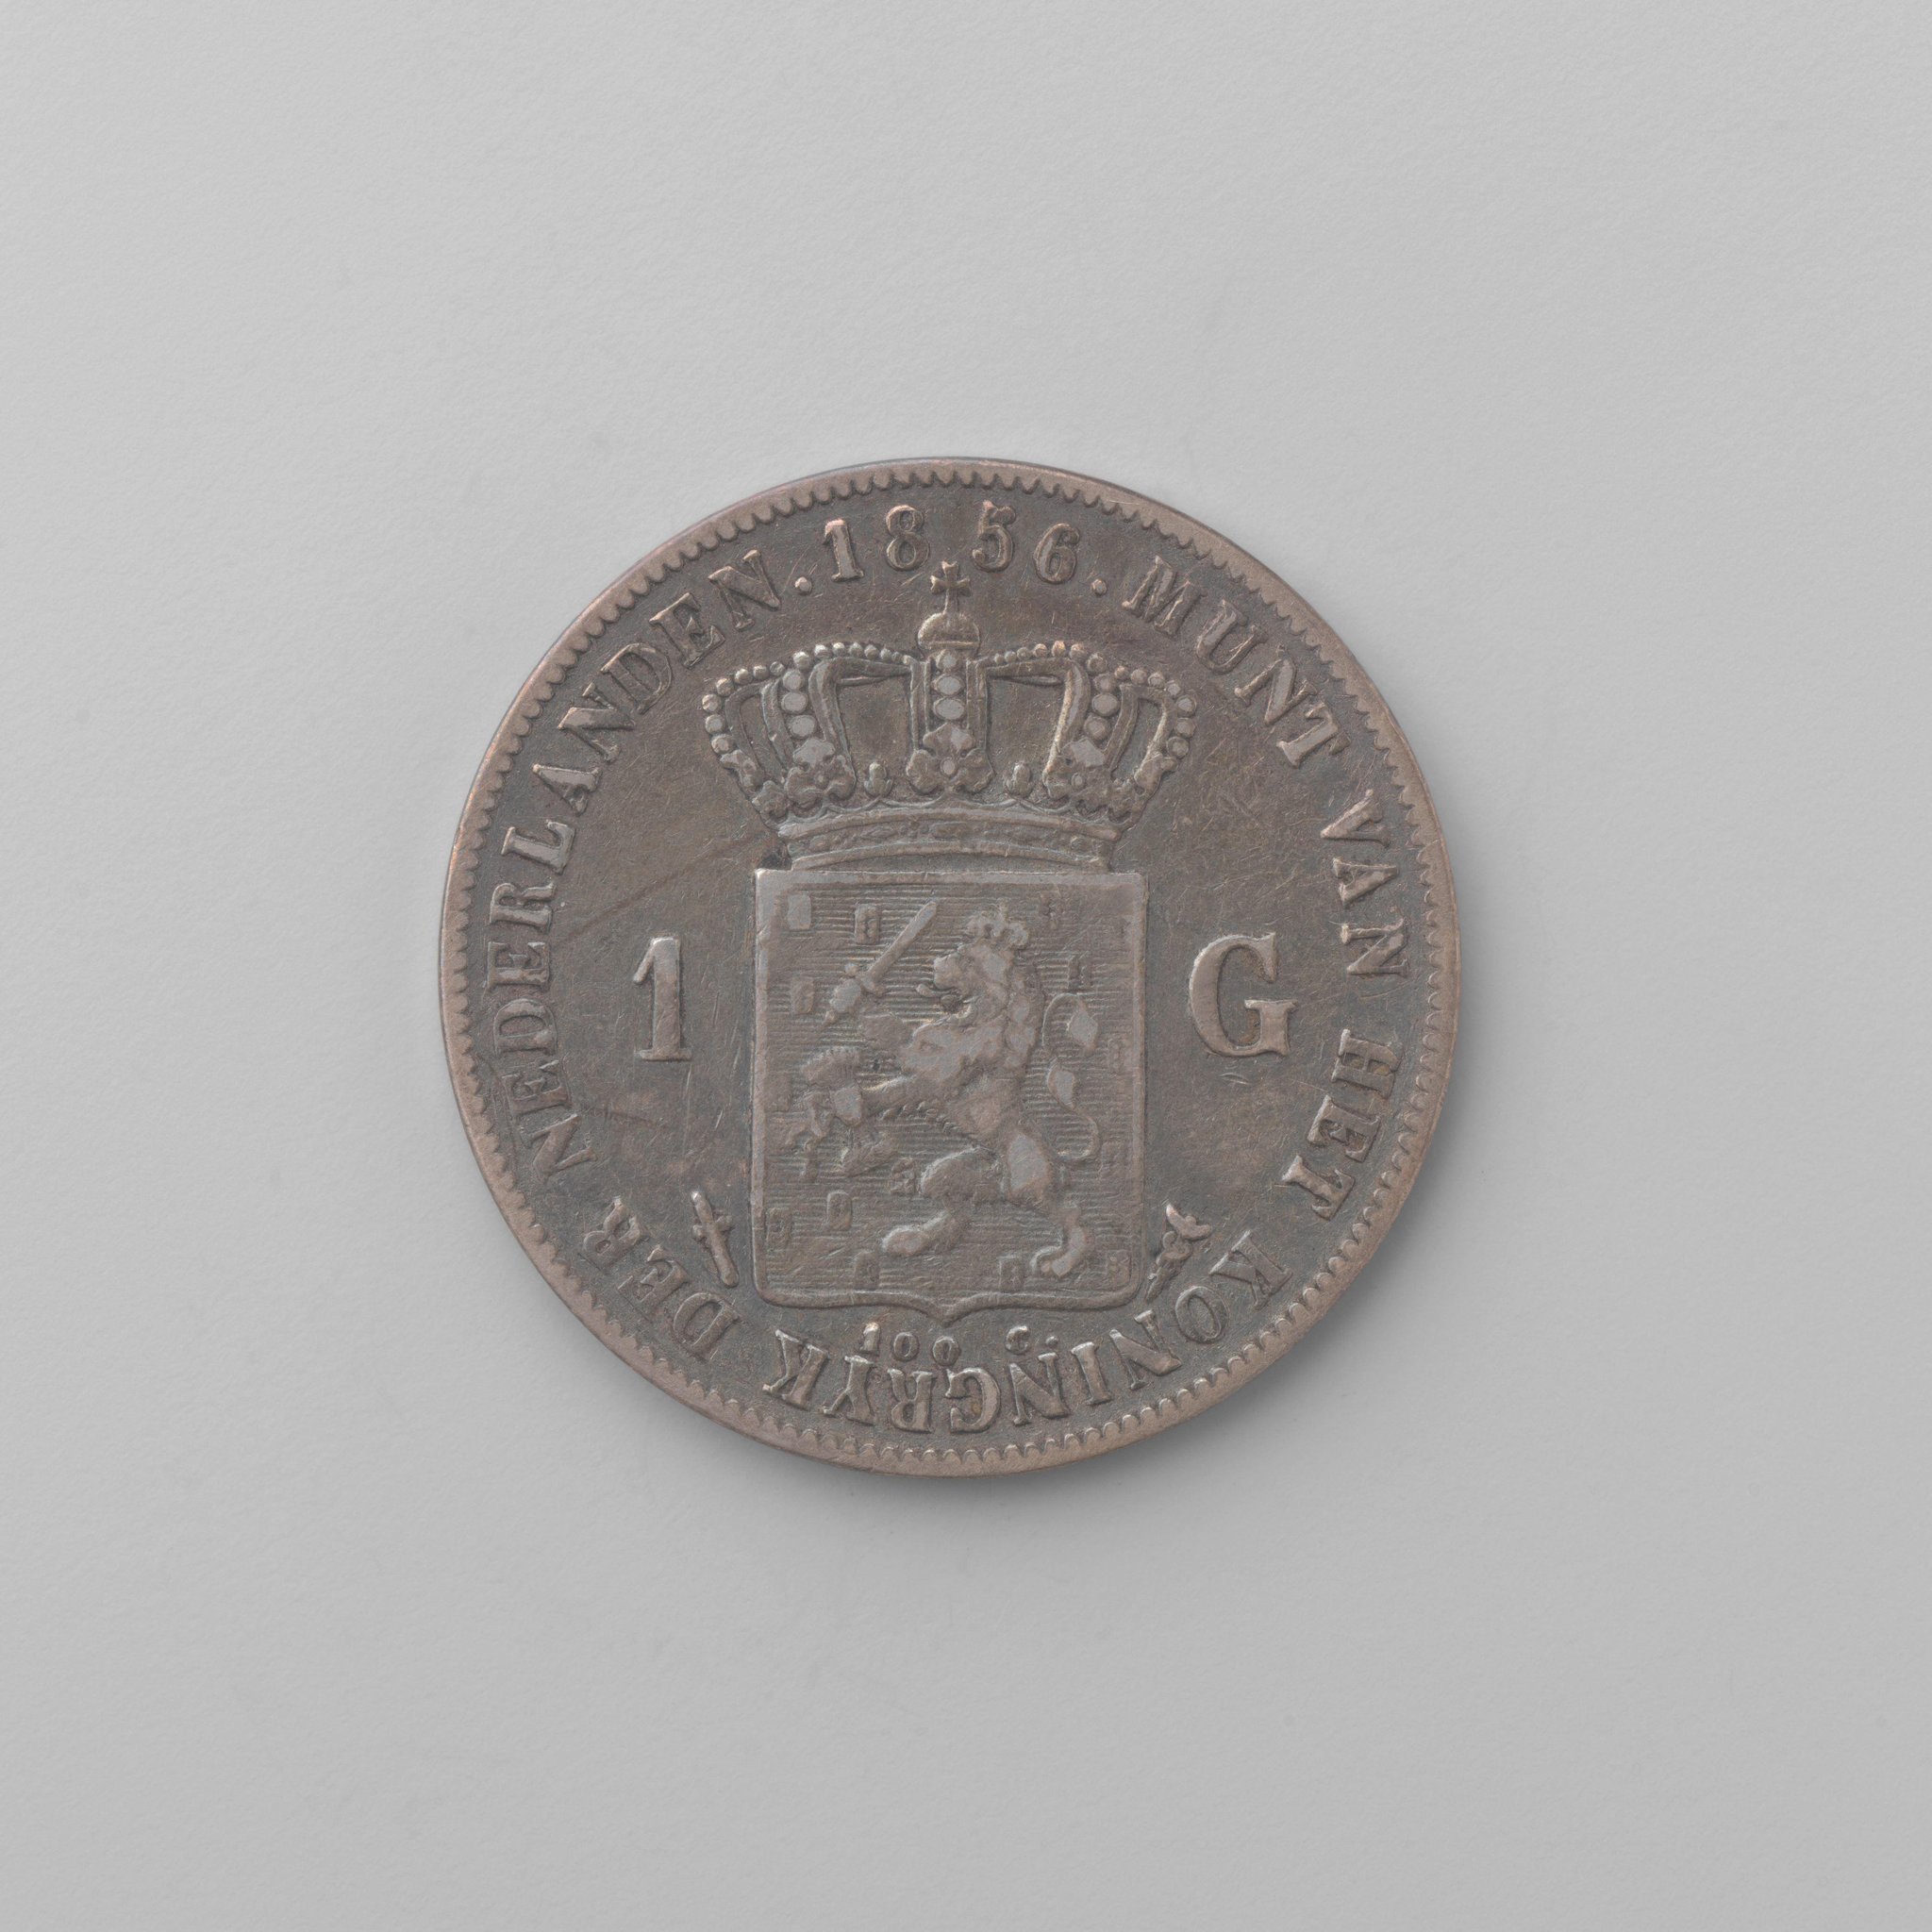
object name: coin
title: Nederlandse gulden, 1856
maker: willem iii (koning der nederlanden)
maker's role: koning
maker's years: 1817-1890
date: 1856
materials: silver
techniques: striking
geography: utrecht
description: Zilveren munt. Voorzijde: borstbeeld naar rechts. Keerzijde: tussen waarde-aanduiding 1 G gekroond rijkswapenschild. Jaartal boven kroon. Randschrift.